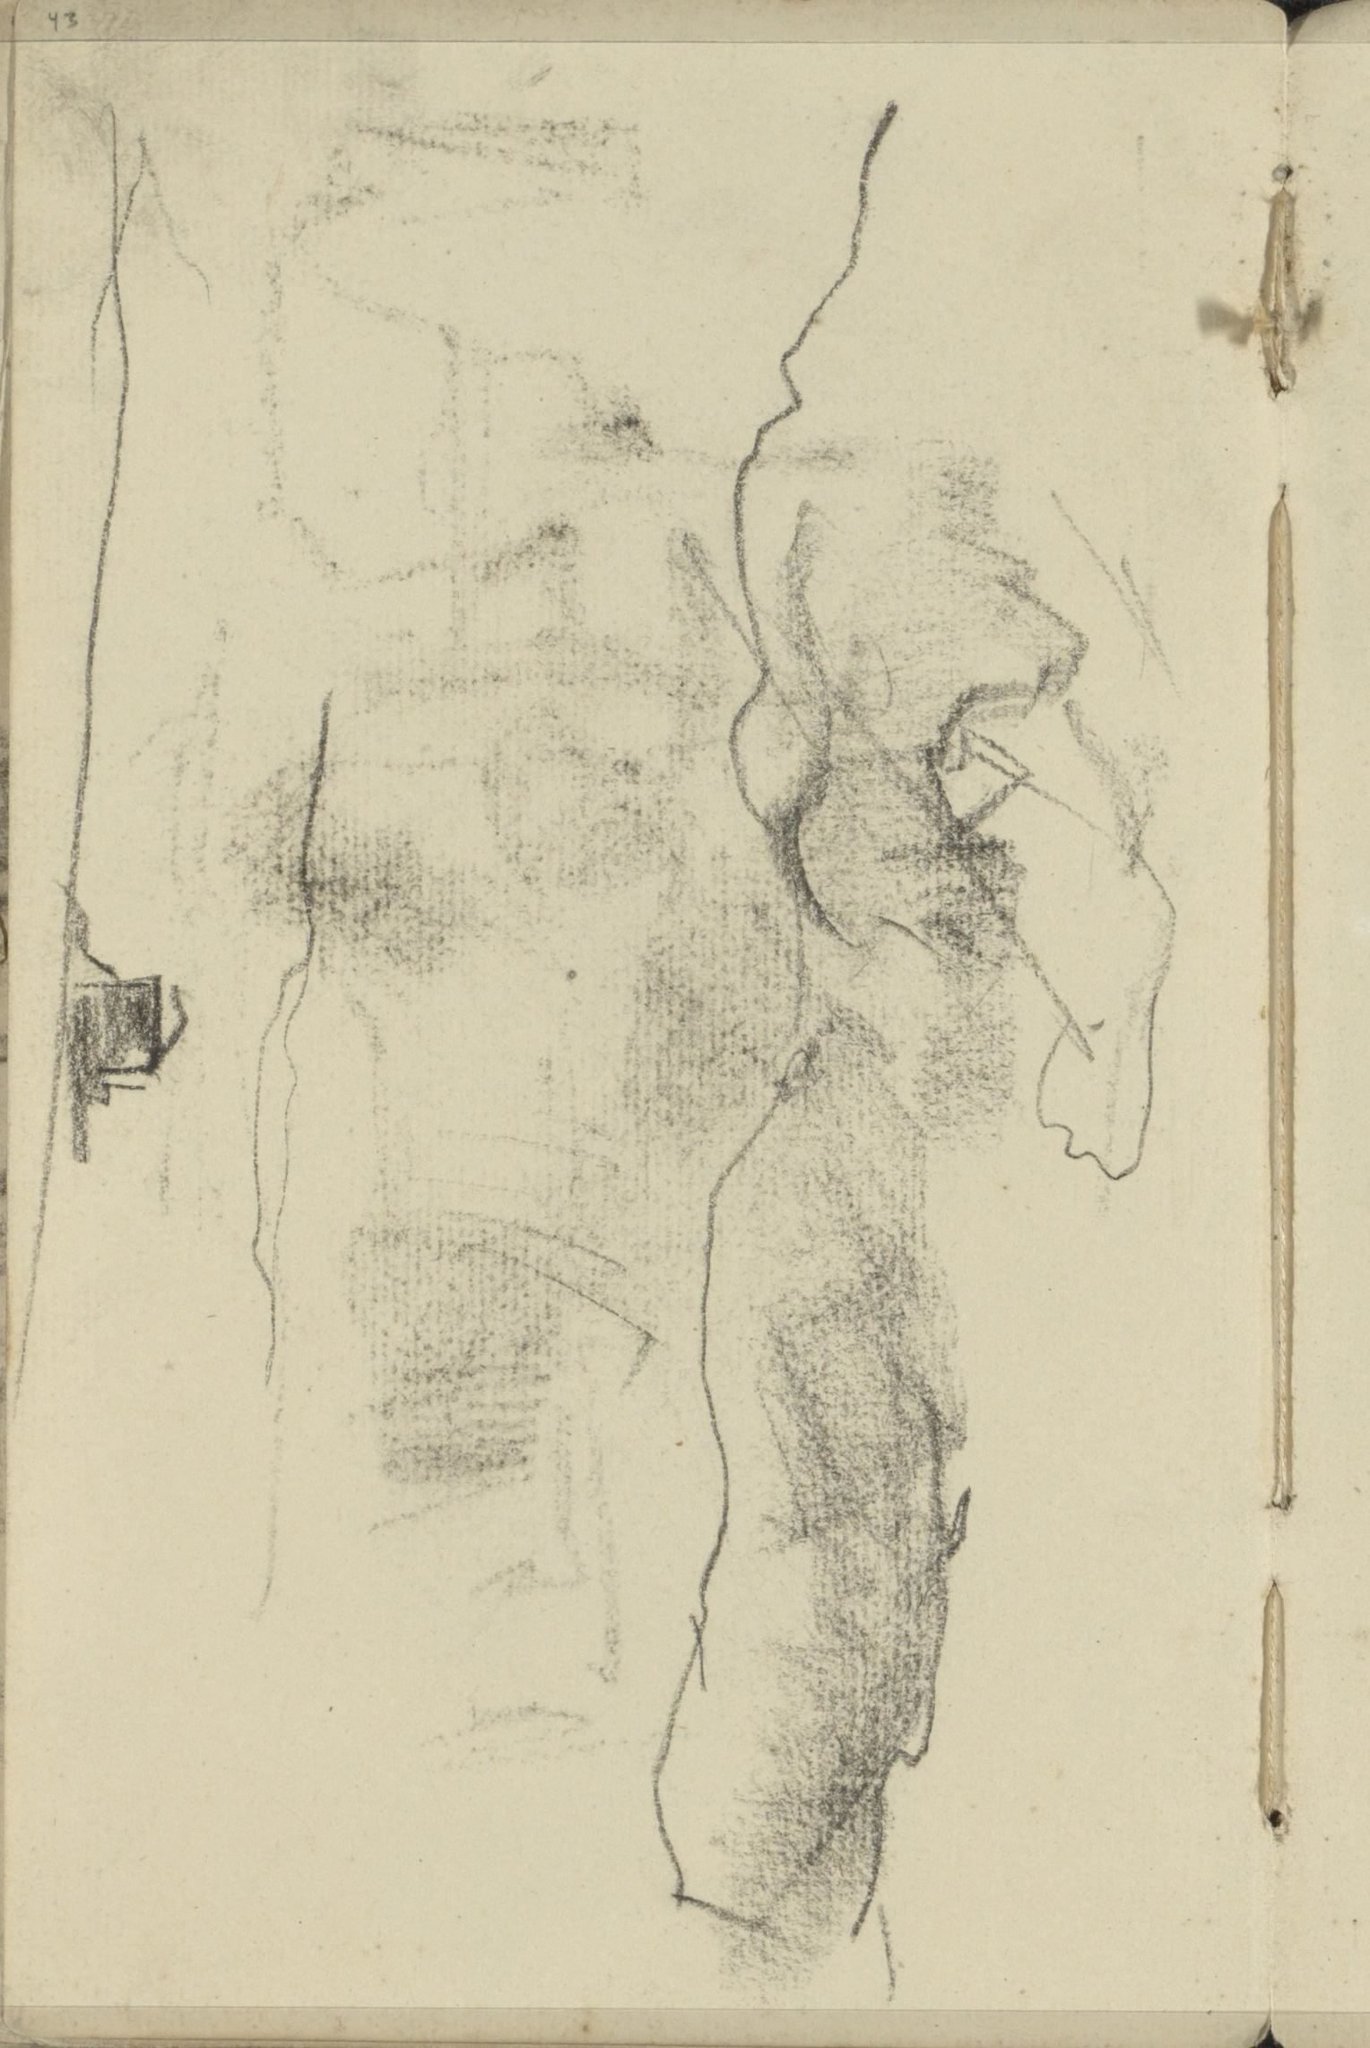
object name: sketchbook leaf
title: Studie, mogelijk van een wolkenlucht boven een landschap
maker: george hendrik breitner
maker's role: draughtsman, painter, print maker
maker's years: 1857-1923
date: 1882-1884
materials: chalk, paper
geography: the hague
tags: landscapes, clouds, civic architecture; edifices; dwellings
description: Pagina 43 uit een schetsboek met 24 bladen.